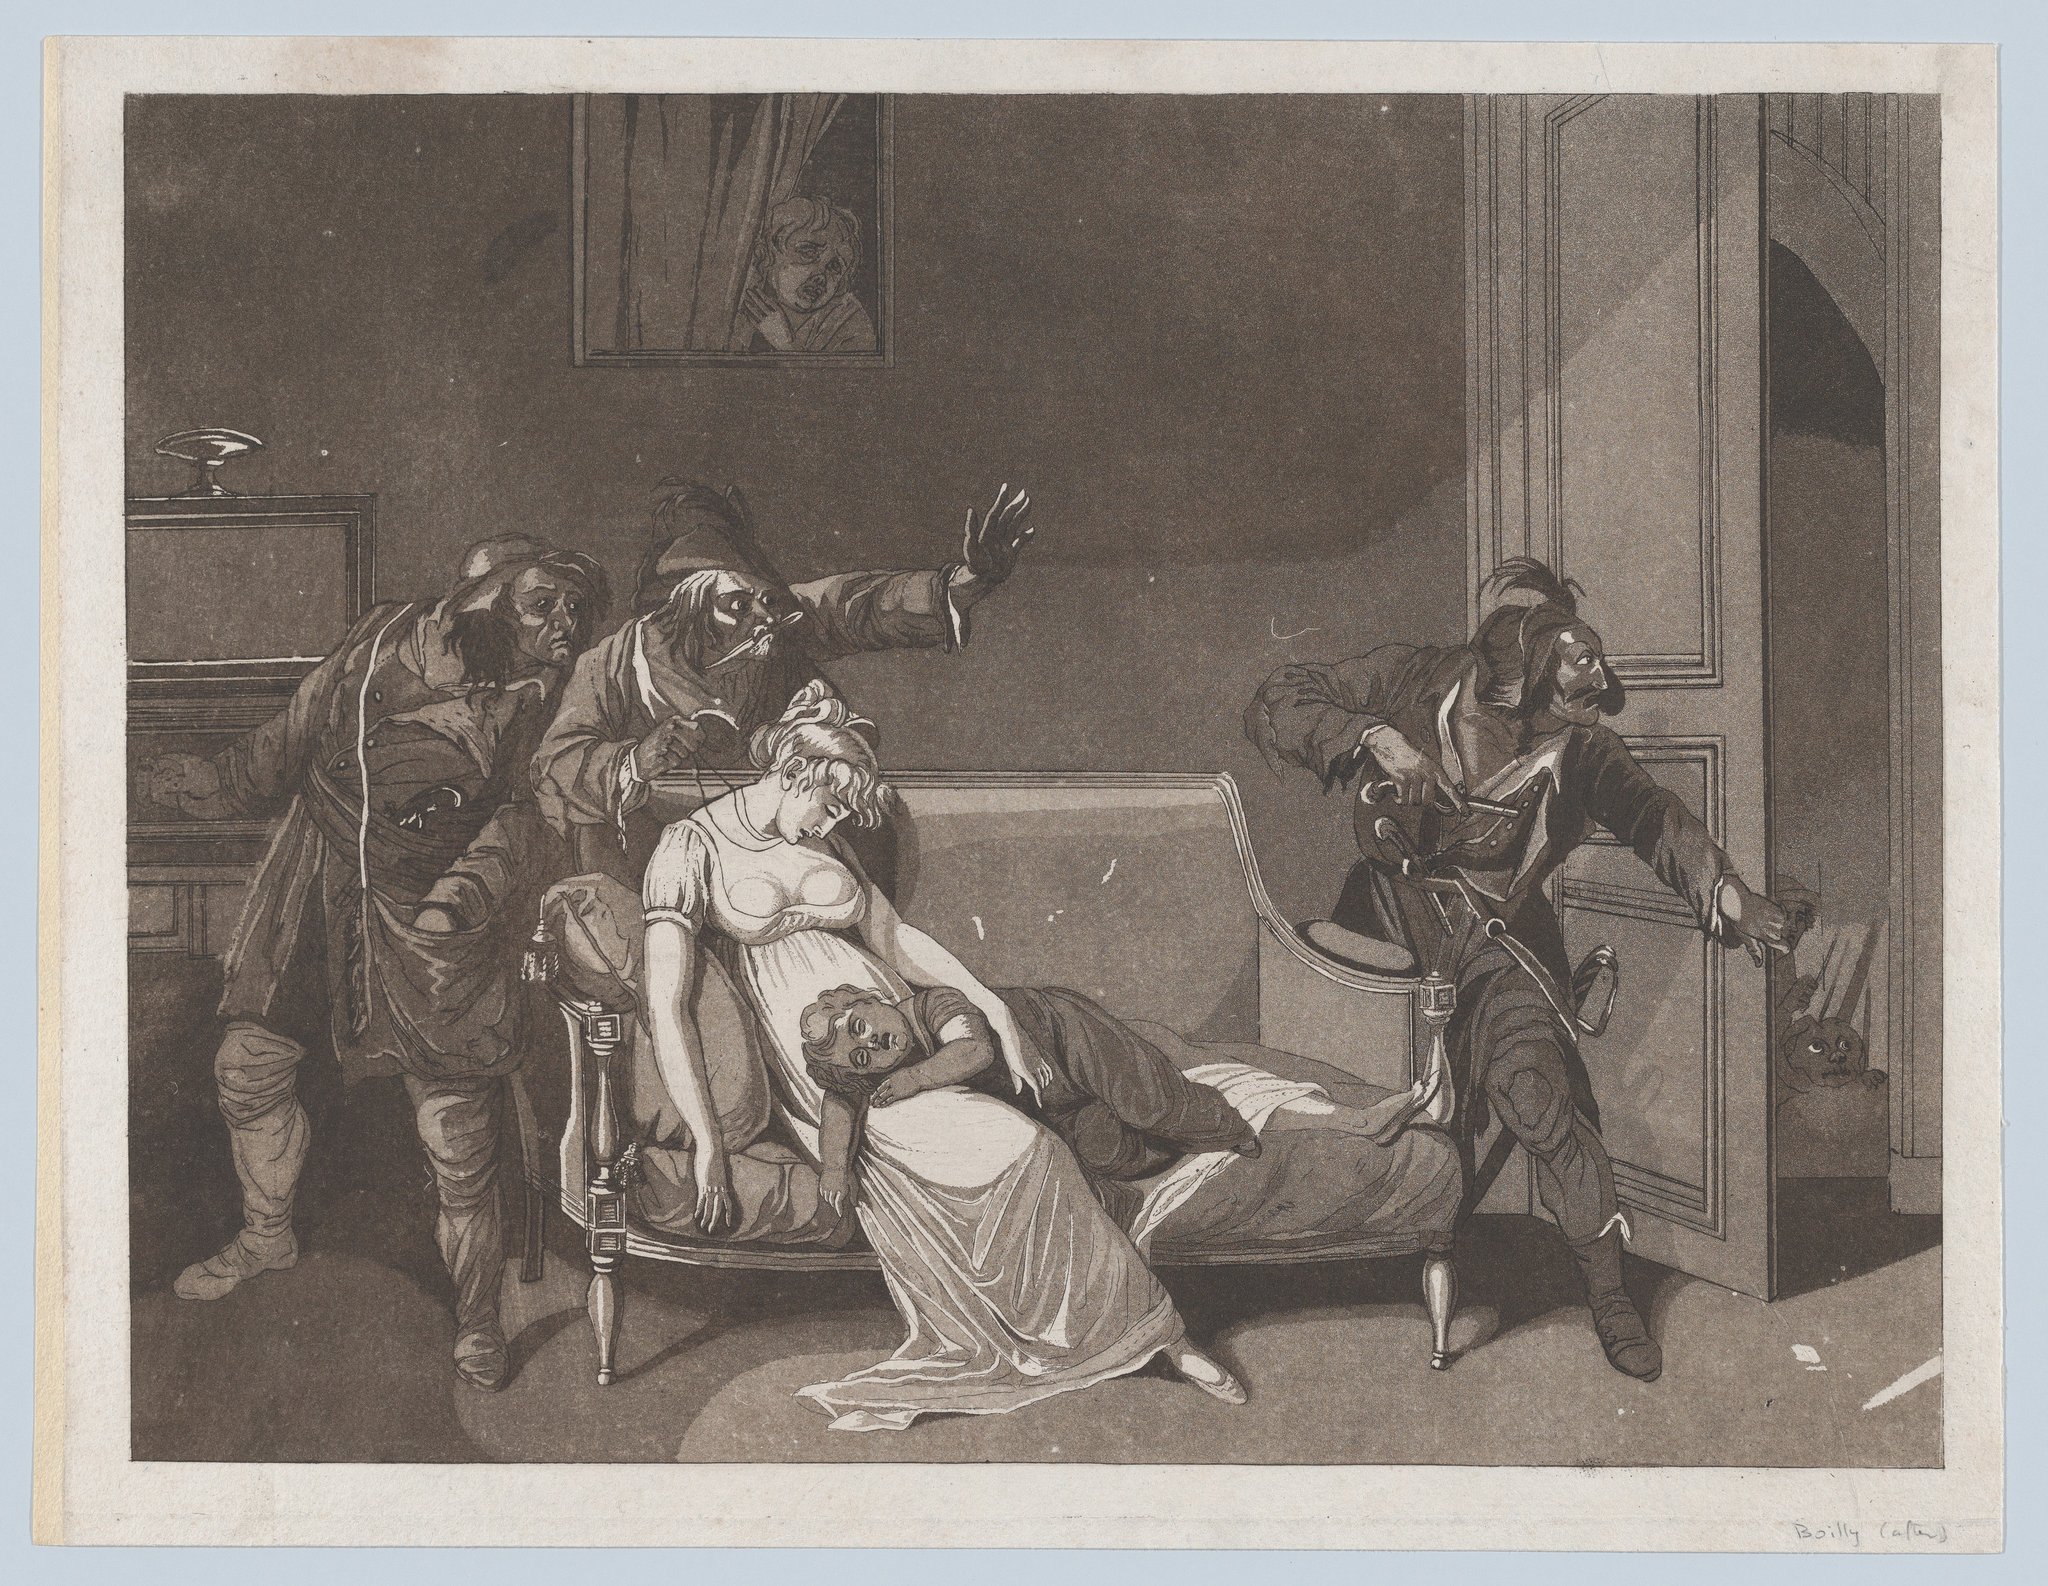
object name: print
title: First Scene of Thieves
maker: gror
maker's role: artist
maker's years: 1800-1850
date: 1805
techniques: aquatint, etching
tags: sleeping,children,men,women